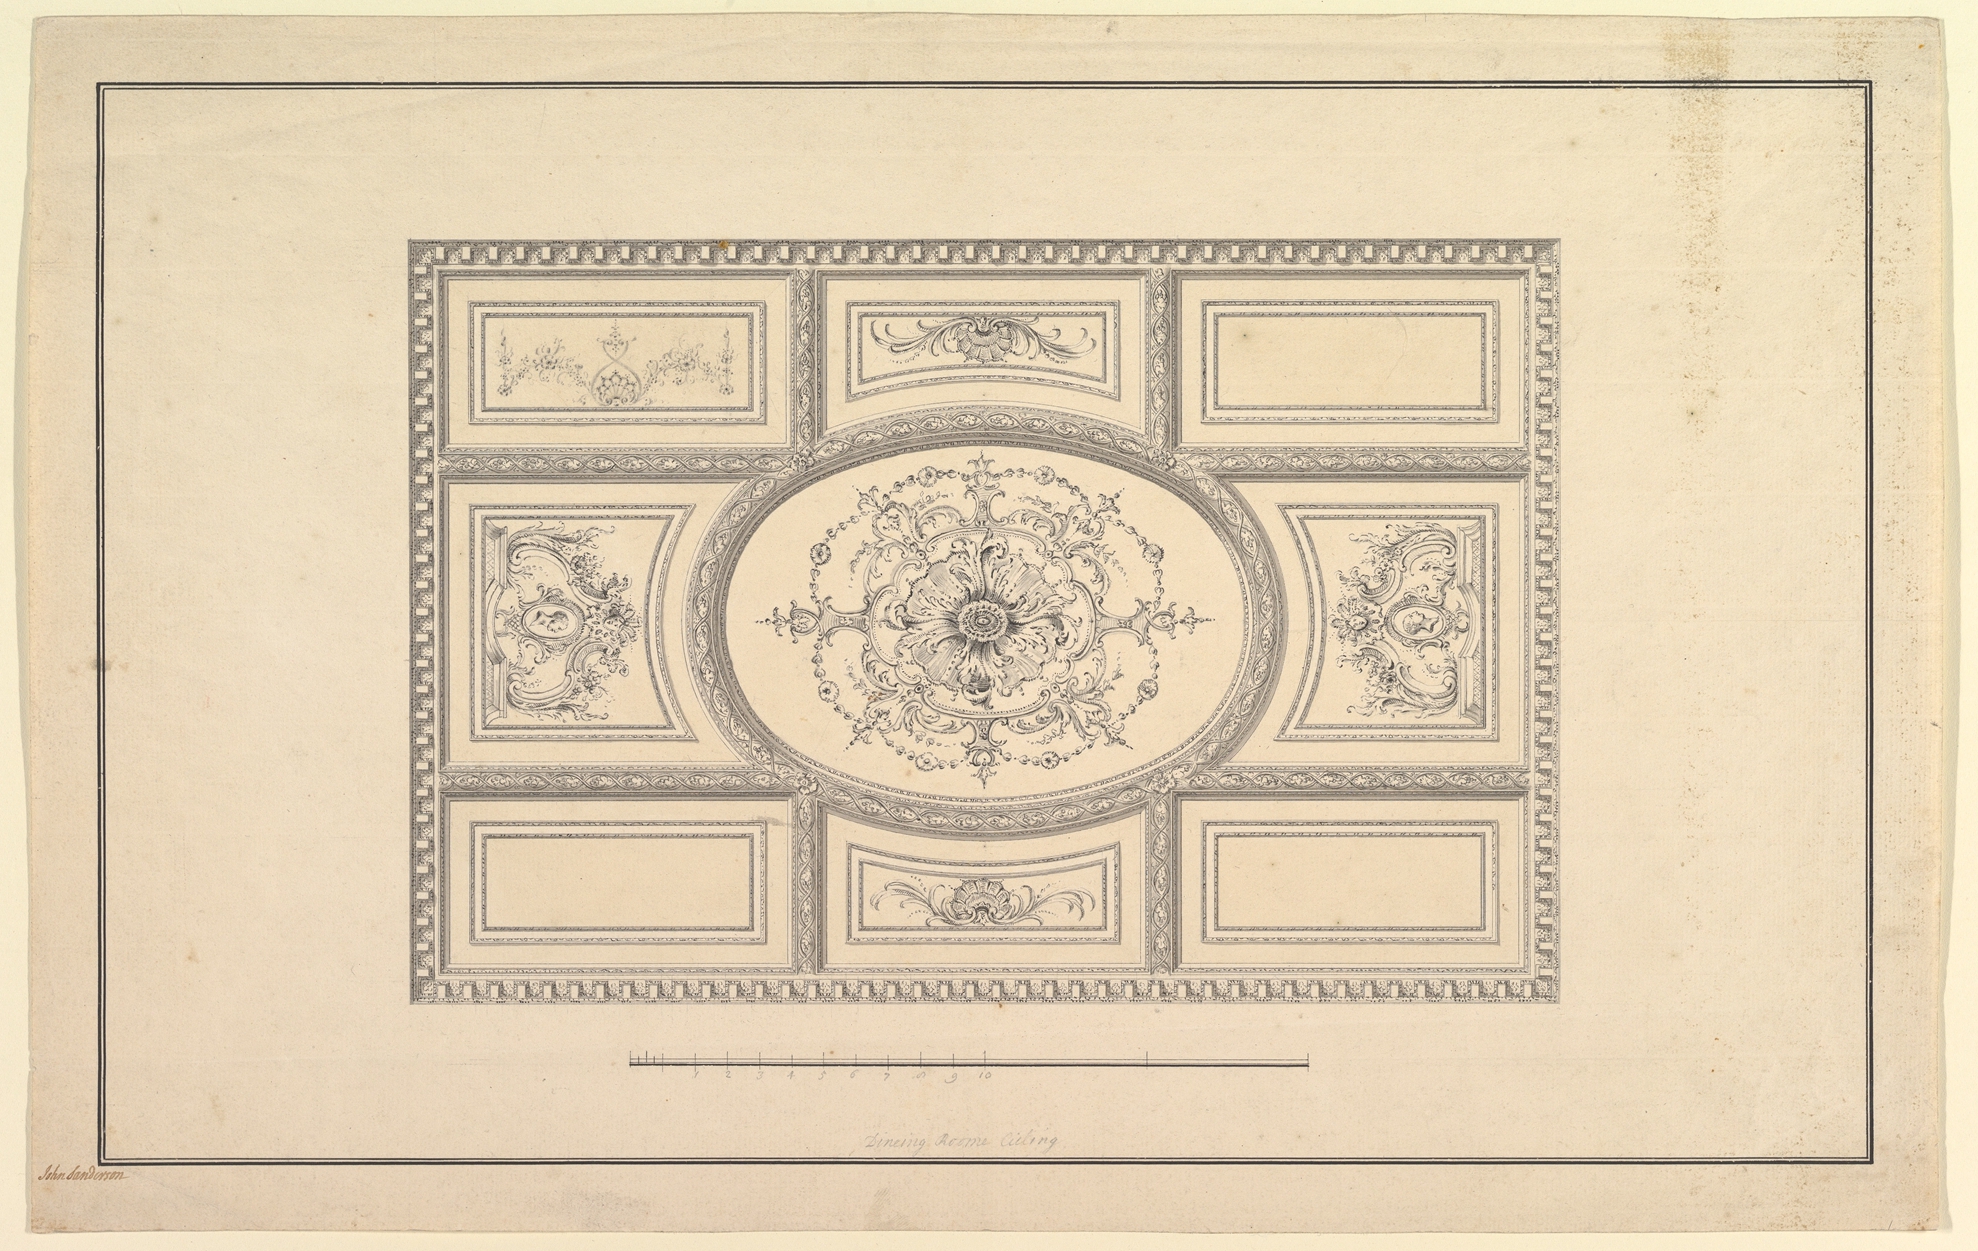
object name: drawing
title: Design for Ceiling at Kirtlington Park, Oxfordshire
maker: john sanderson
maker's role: artist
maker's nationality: british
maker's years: 1730-1774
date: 1747-1748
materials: ink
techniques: pen, wash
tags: ceilings